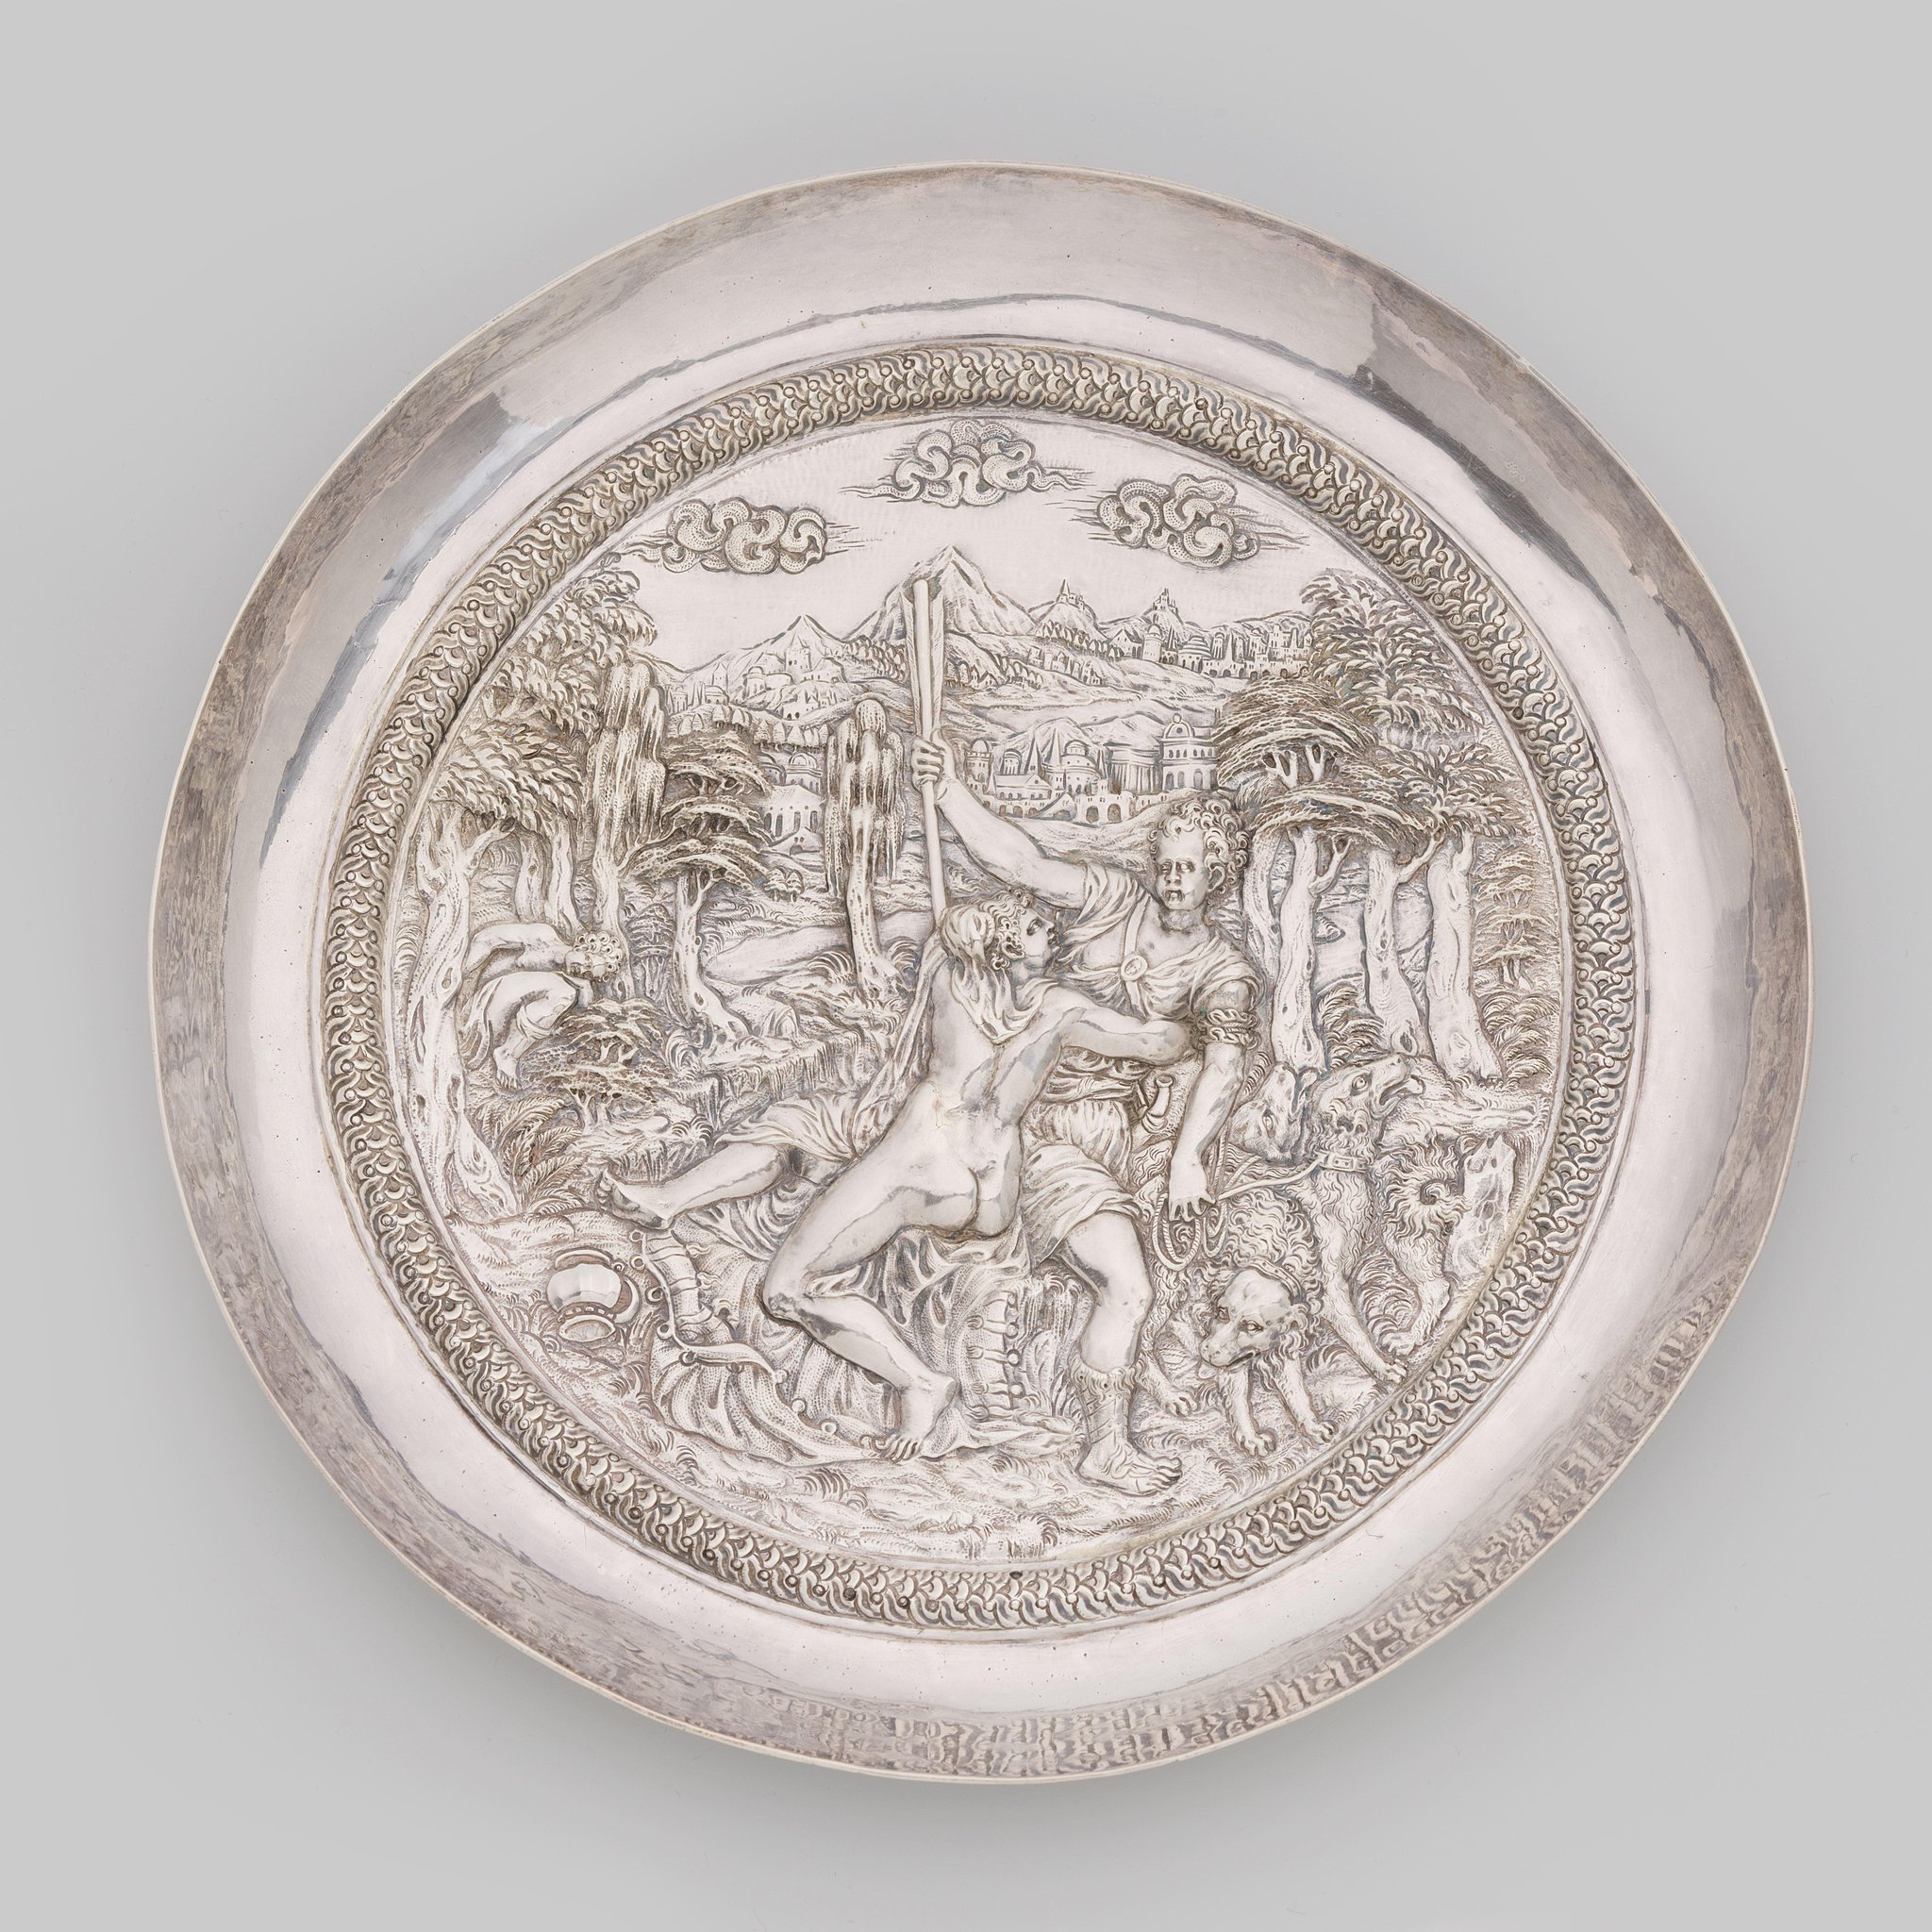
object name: fragment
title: Drinkschaal met Venus en Adonis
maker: hans jamnitzer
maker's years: 1539-1603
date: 1550-1575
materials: silver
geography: nuremberg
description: Tazza with Venus and Adonis. Silver. Nuremberg (?), c. 1550-1575. Dagger and sheath. Silver and iron. Germany?, c. 1540.